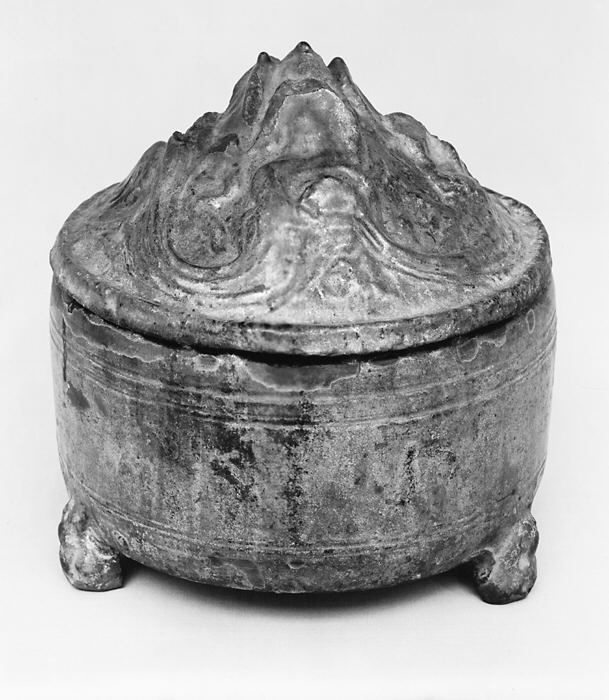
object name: jar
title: Hill Jar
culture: chinese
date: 206 BCE-220 CE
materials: earthenware